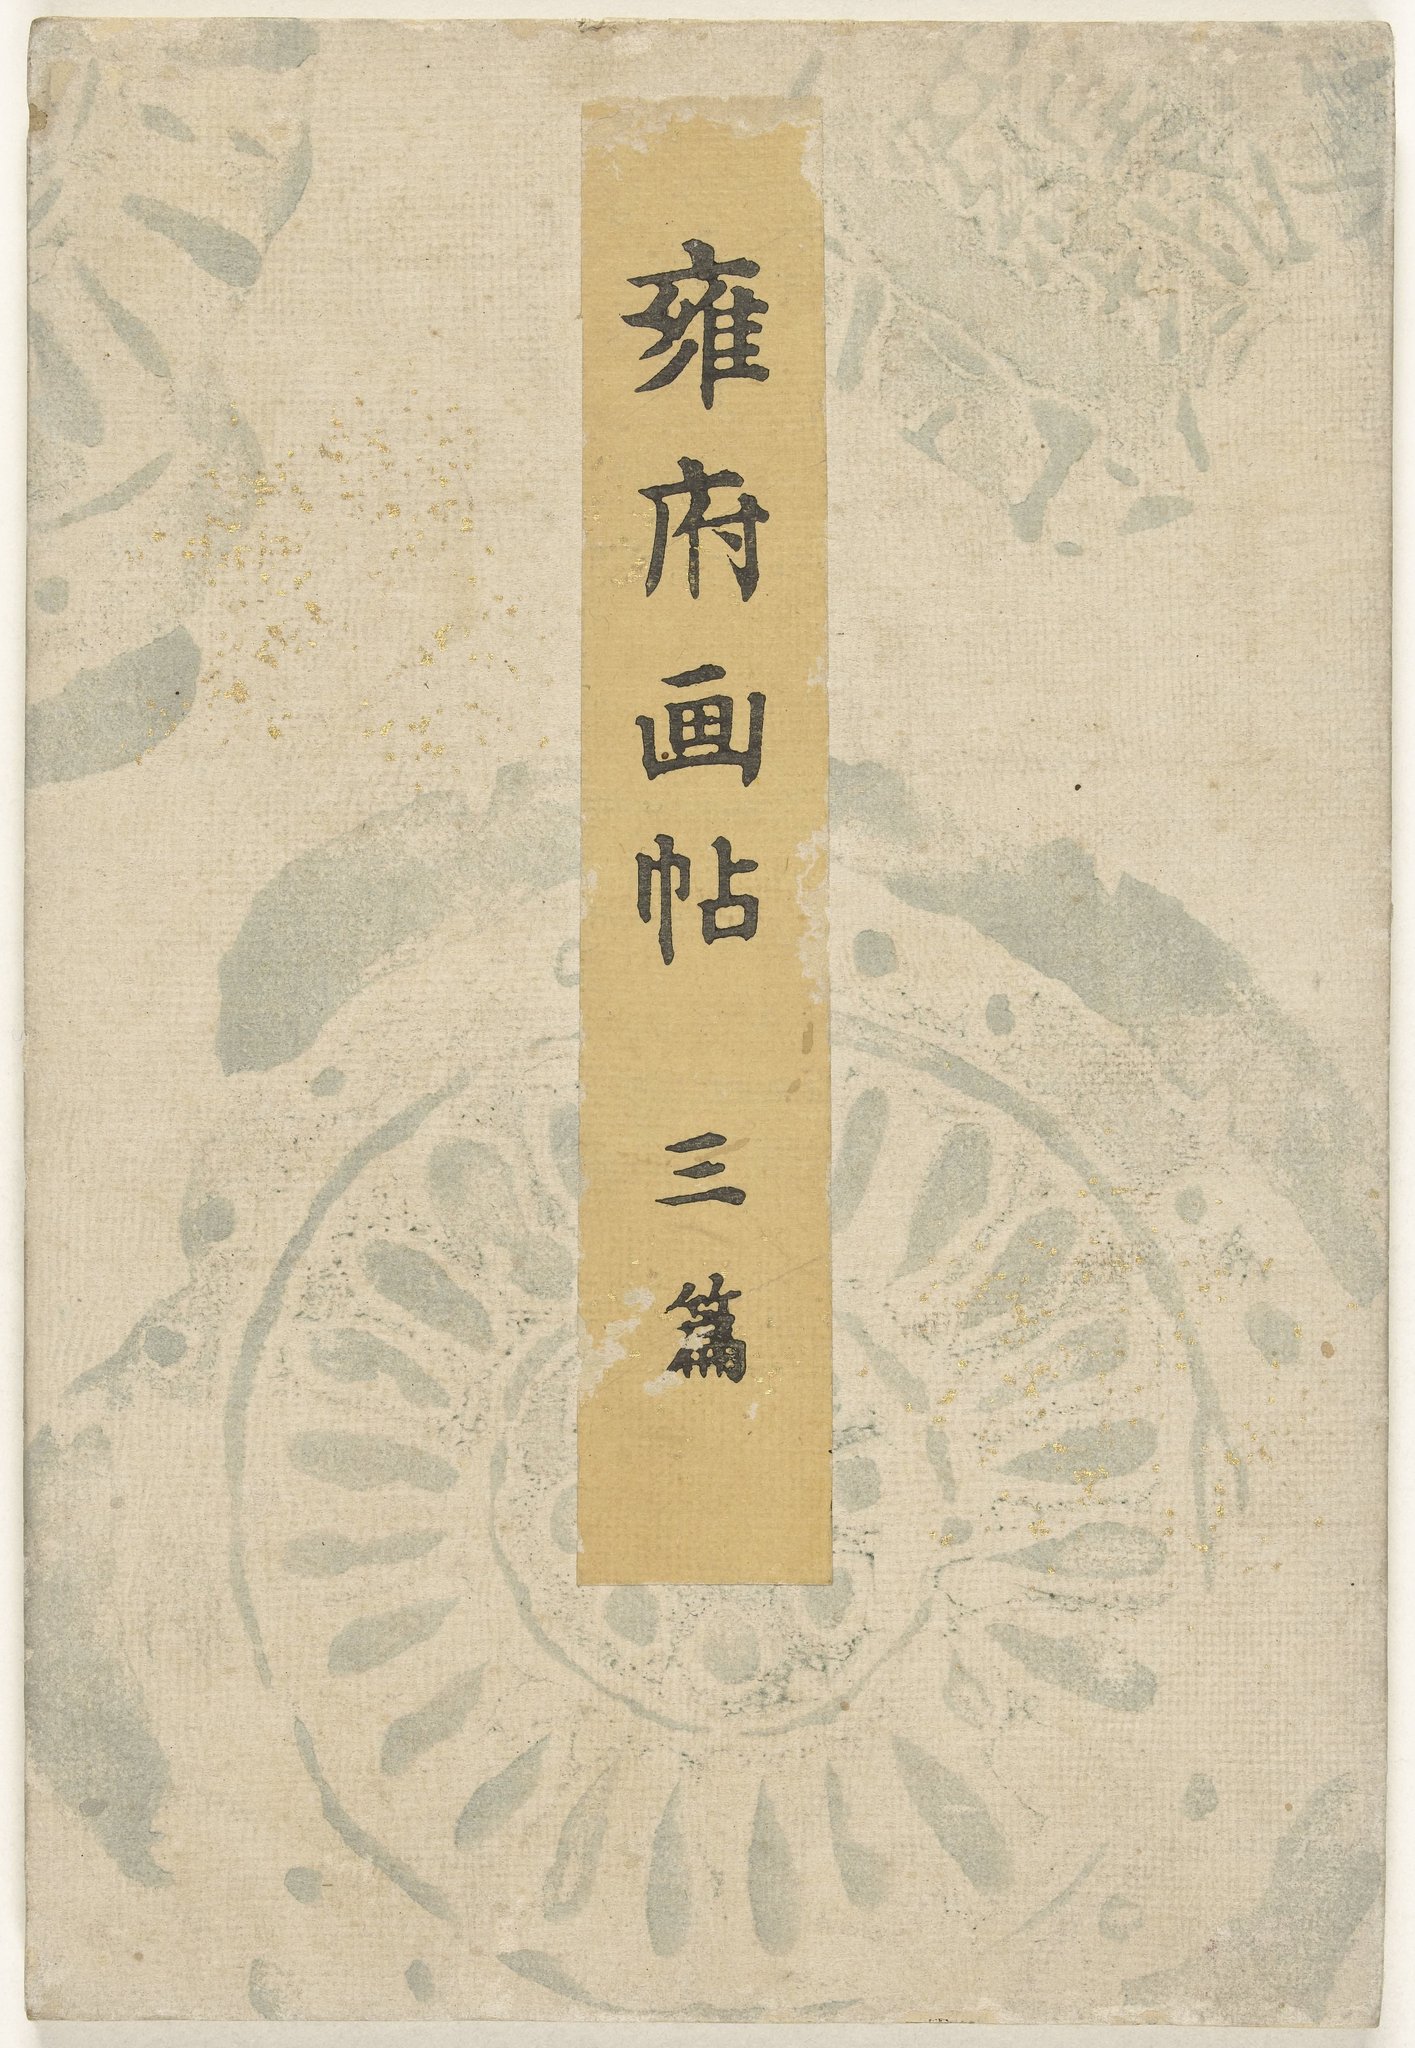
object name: book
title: Yofu gacho - sanpen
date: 1898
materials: paper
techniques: woodcut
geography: kyoto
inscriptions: collector's mark: Lugt 2228